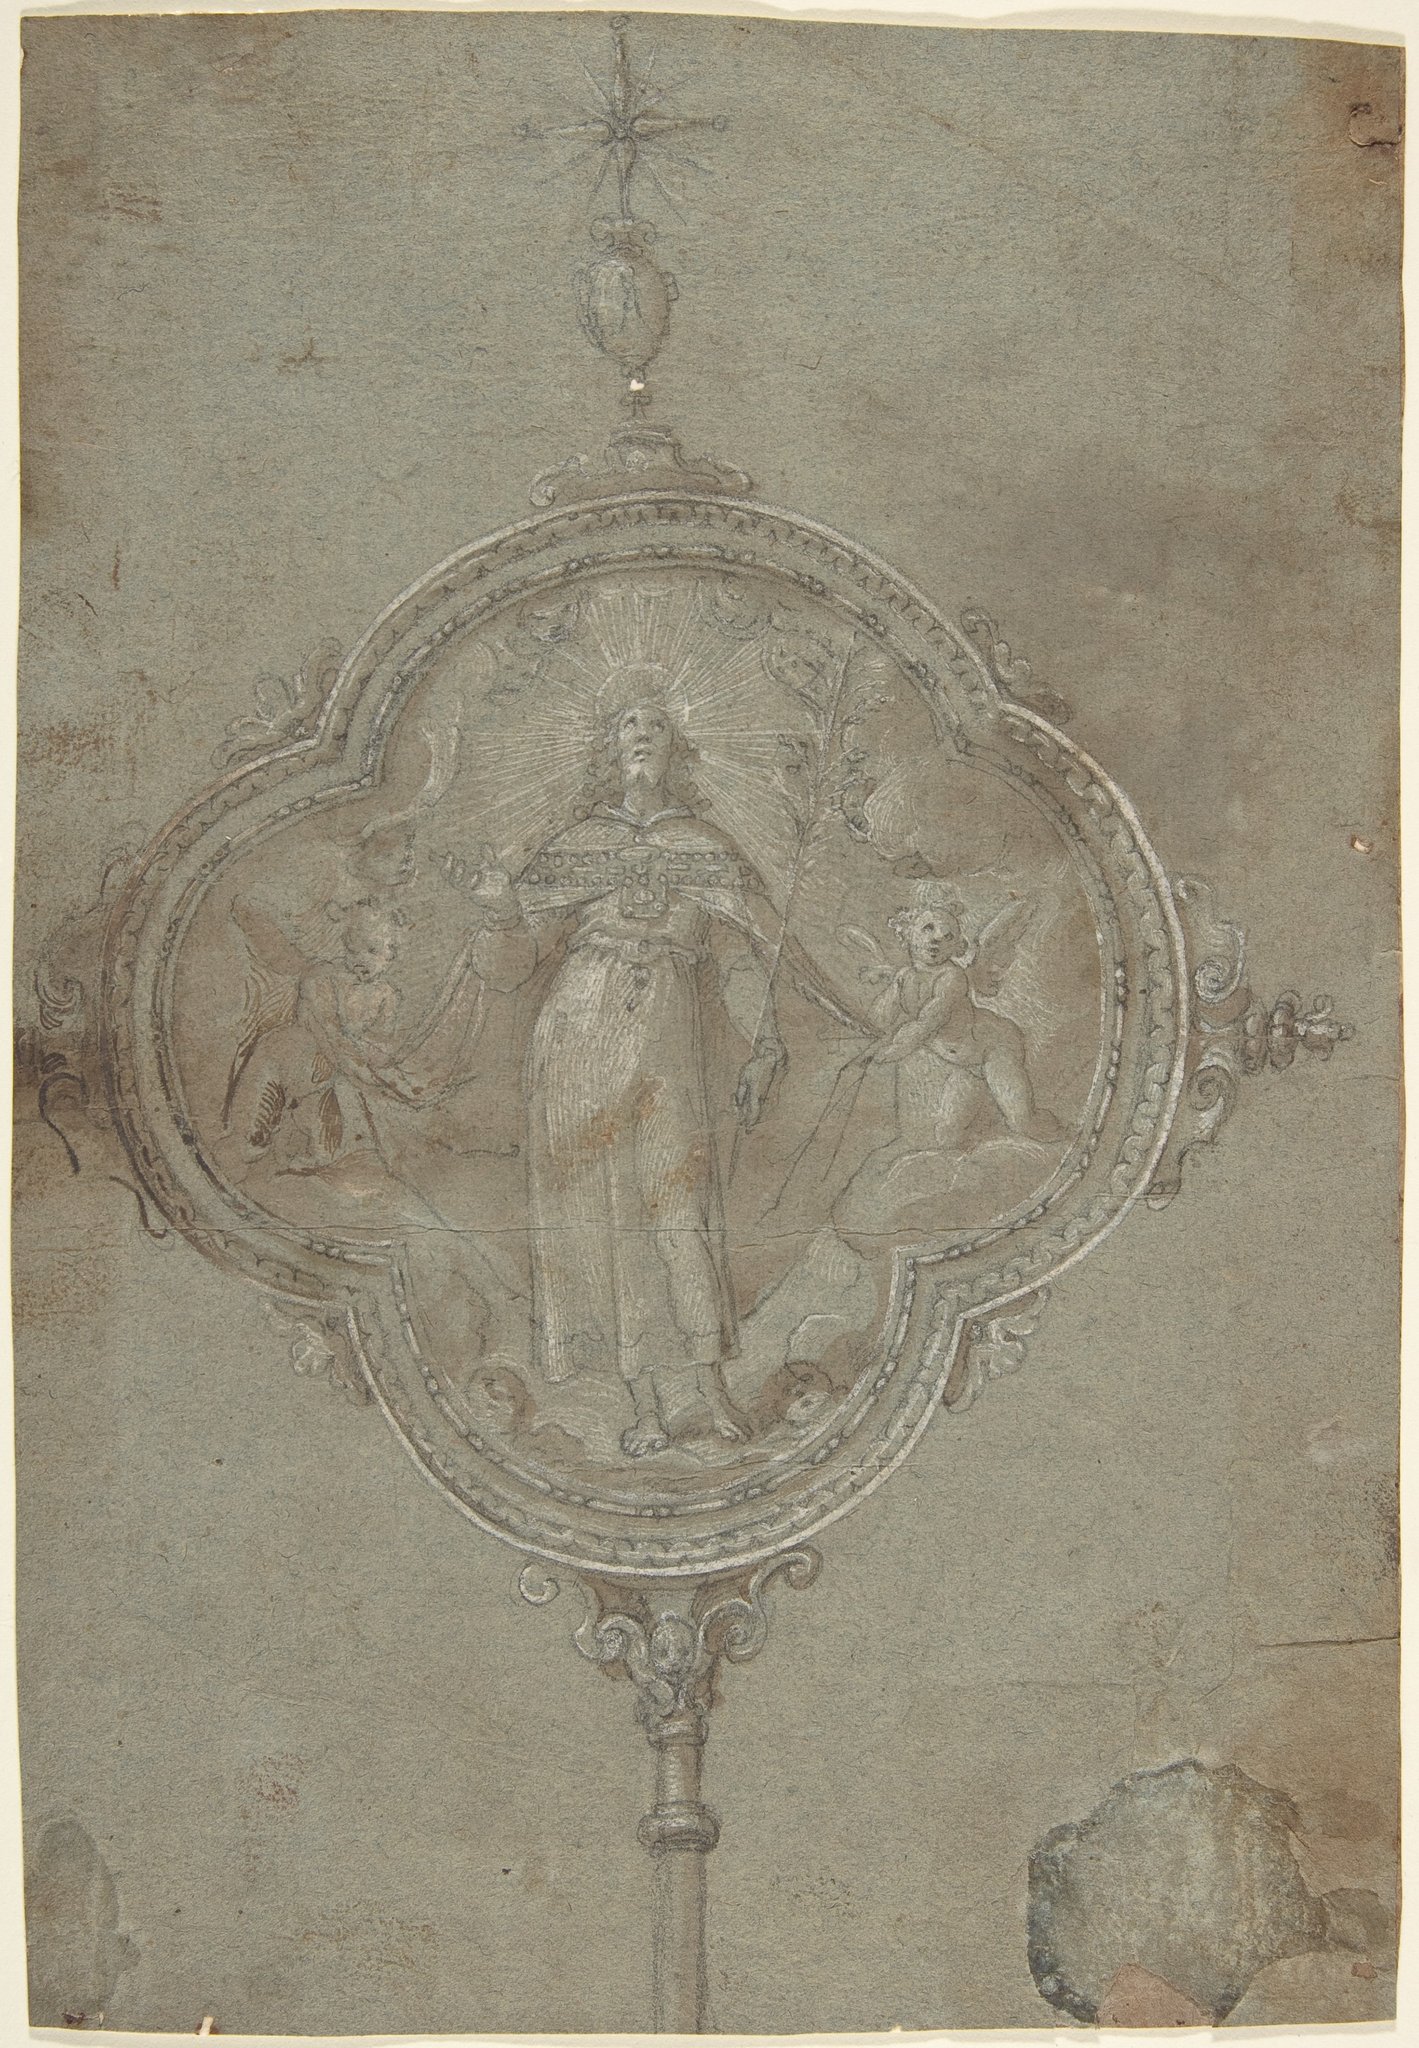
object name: drawing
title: Drawing for a Standard with Christ in Glory Flanked by Putti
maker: anonymous, italian, florentine, 16th century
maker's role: artist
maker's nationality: italian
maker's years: 1500-1600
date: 1501-1600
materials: chalk, gouache, ink, paper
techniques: highlighting, wash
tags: putti,christ